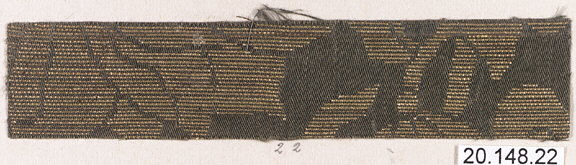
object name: piece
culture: japanese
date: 1301-1400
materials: silk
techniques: compound weave